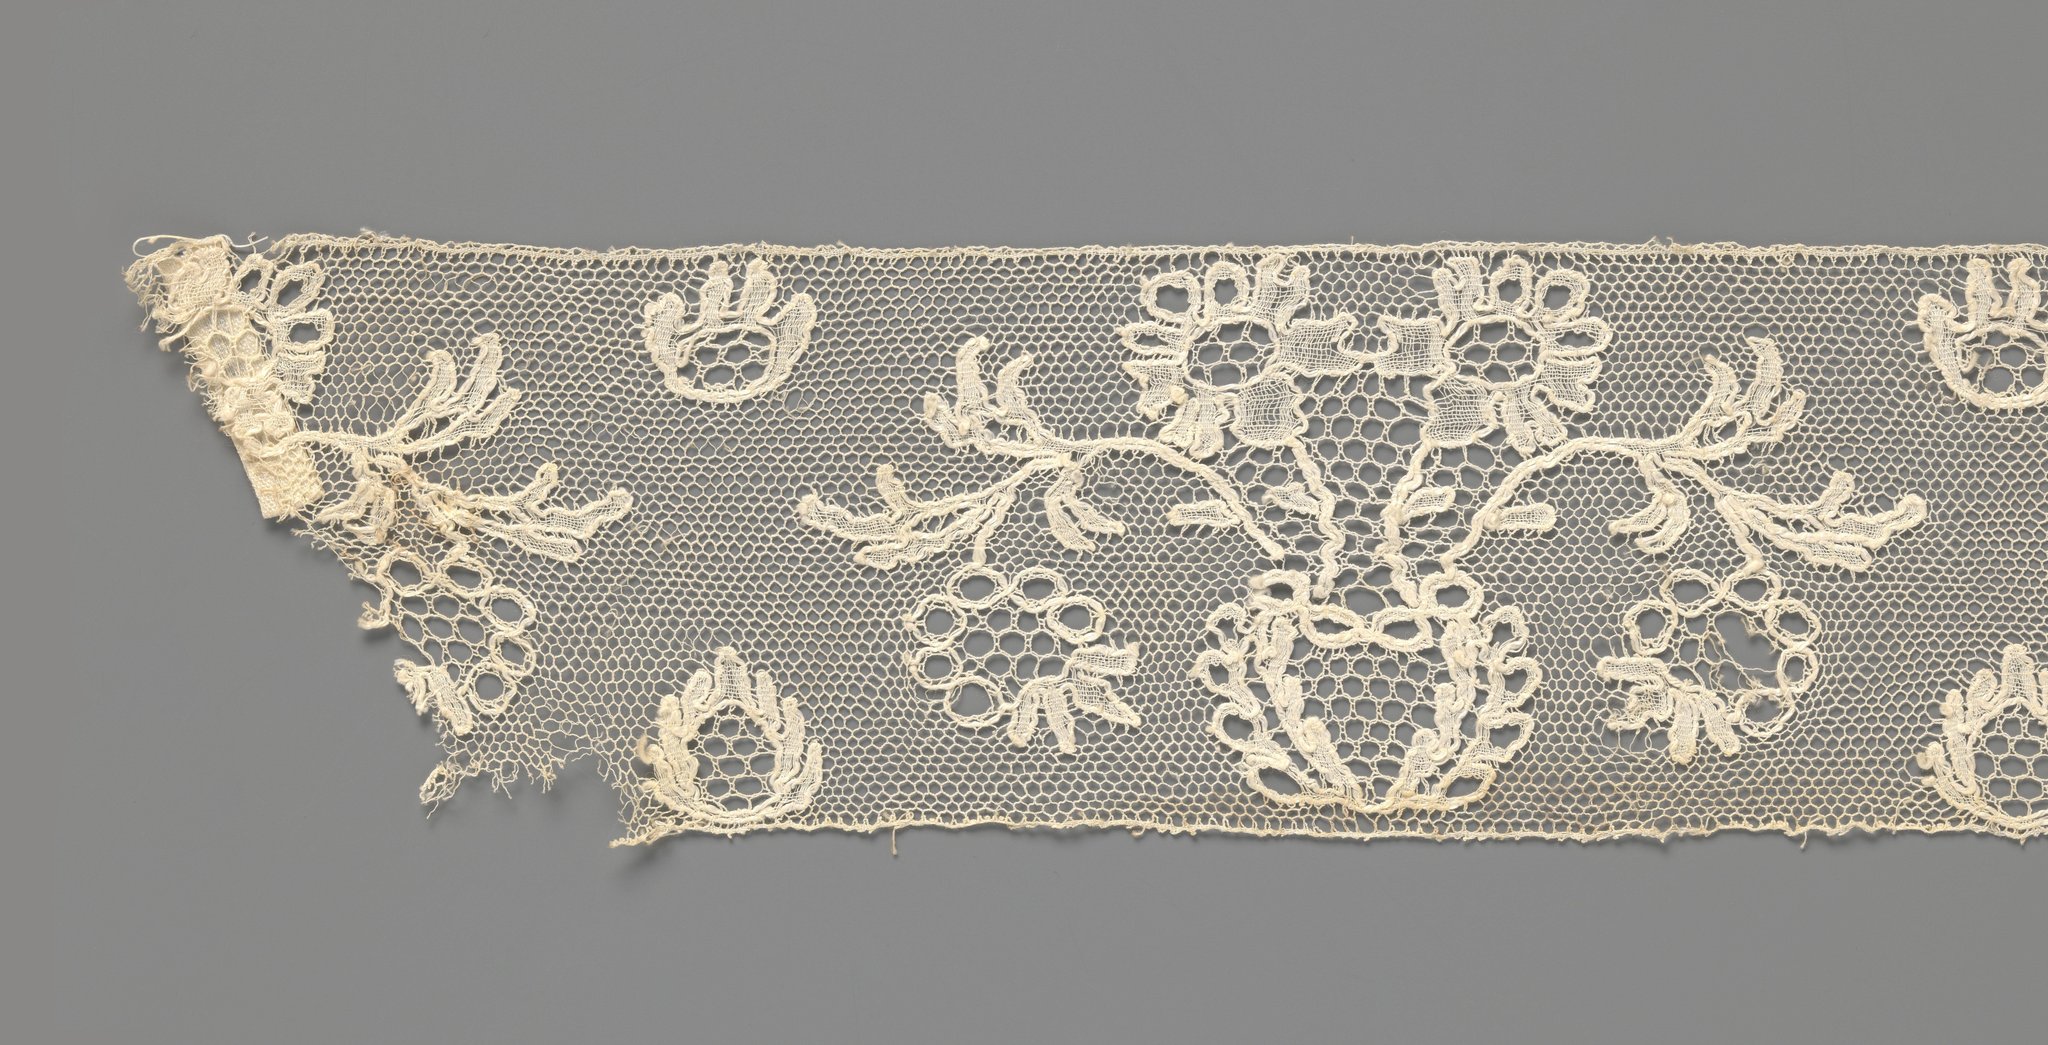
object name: strip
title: Strook kloskant met bolvormige bloempot en aardbei-vormige bloem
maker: Anonymous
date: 1875-1899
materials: cotton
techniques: lace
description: Strook naturelkleurige kloskant: Beverse kant. Het zich herhalende en symmetrische patroon bestaat uit een bolvormige bloempot met twee rozetbloemen in het midden en daarnaast aan elke kant een gebogen tak met een naar de pot toegewende aardbei-vormige bloem. Tussen de opeenvolgende potten staat langs de bovenzijde een ovaal met een kroon en recht daaronder een eivormig motief omhuld door smalle bladeren. De motieven zijn met elkaar verbonden door een fijne traliegrond, een tulegrond. De motieven zijn gemaakt in linnenslag met grote uitsparingen en dikkere, glimmende contourdraden. Als siergrond is een rozengrond toegepast en op enkele plekken is een versiering gerealiseerd door overstekende paren. De boven- en onderzijde van de strook zijn recht afgewerkt.